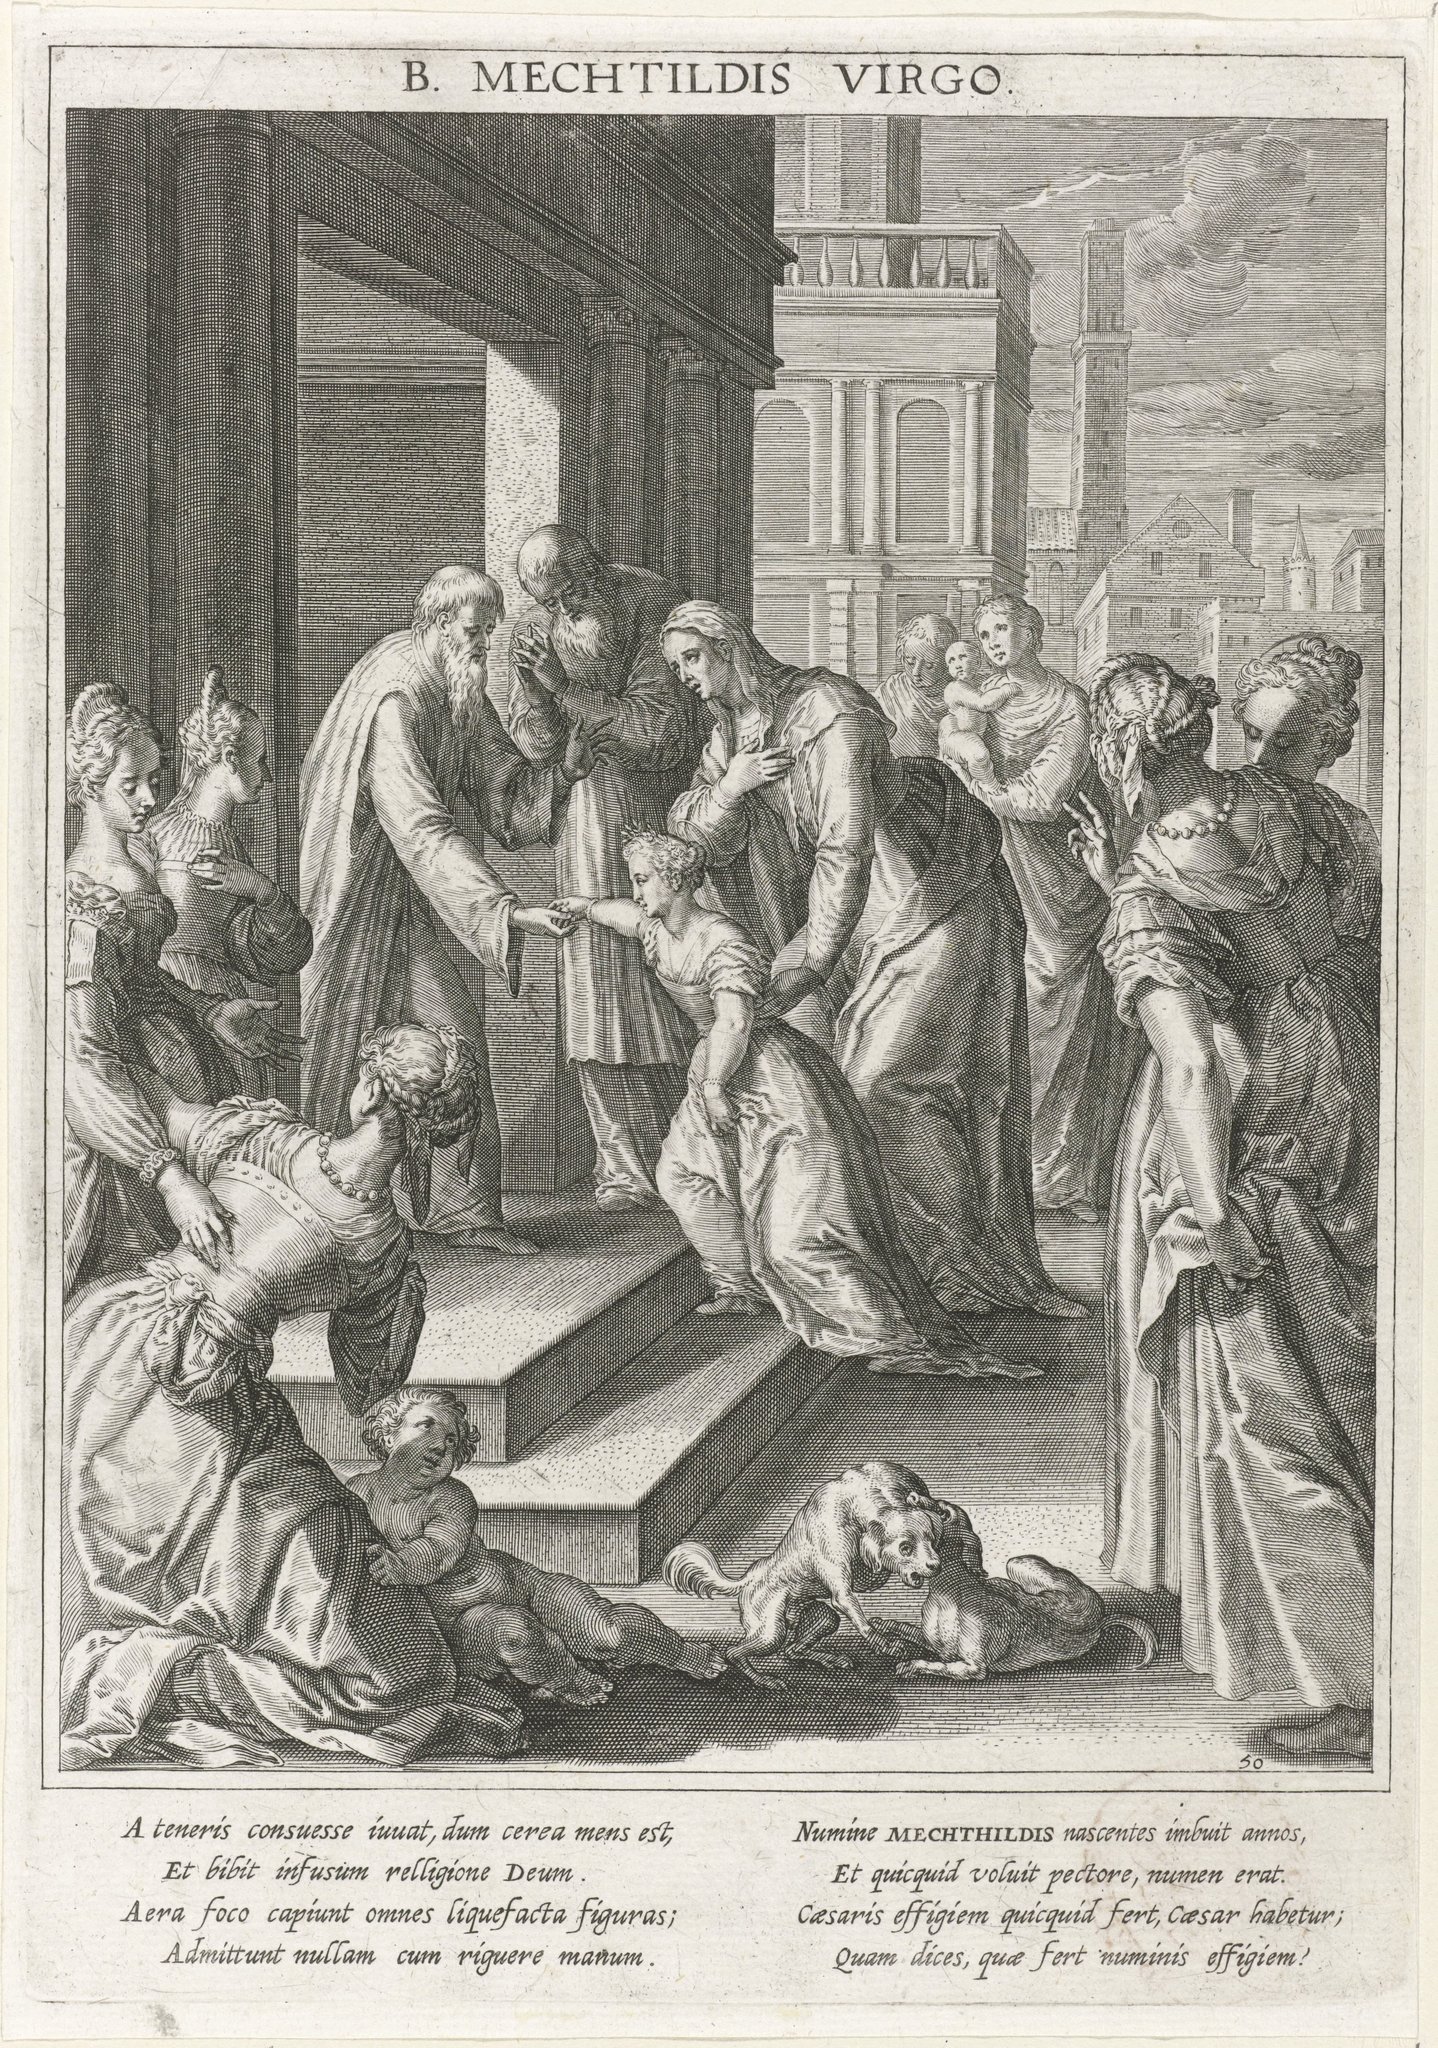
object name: print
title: Heiligen van Beieren I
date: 1615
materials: paper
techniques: engraving, etching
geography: munich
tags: female saints (with name), abbey, monastery, convent ~ roman catholic church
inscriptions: collector's mark: Lugt 240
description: De H. Mechthildis van Diessen wordt op jonge leeftijd door haar ouders naar het klooster van Diessen gebracht. De prent heeft een Latijns onderschrift en is de 50ste prent van een 60-delige serie met als onderwerp de heiligen van Beieren.